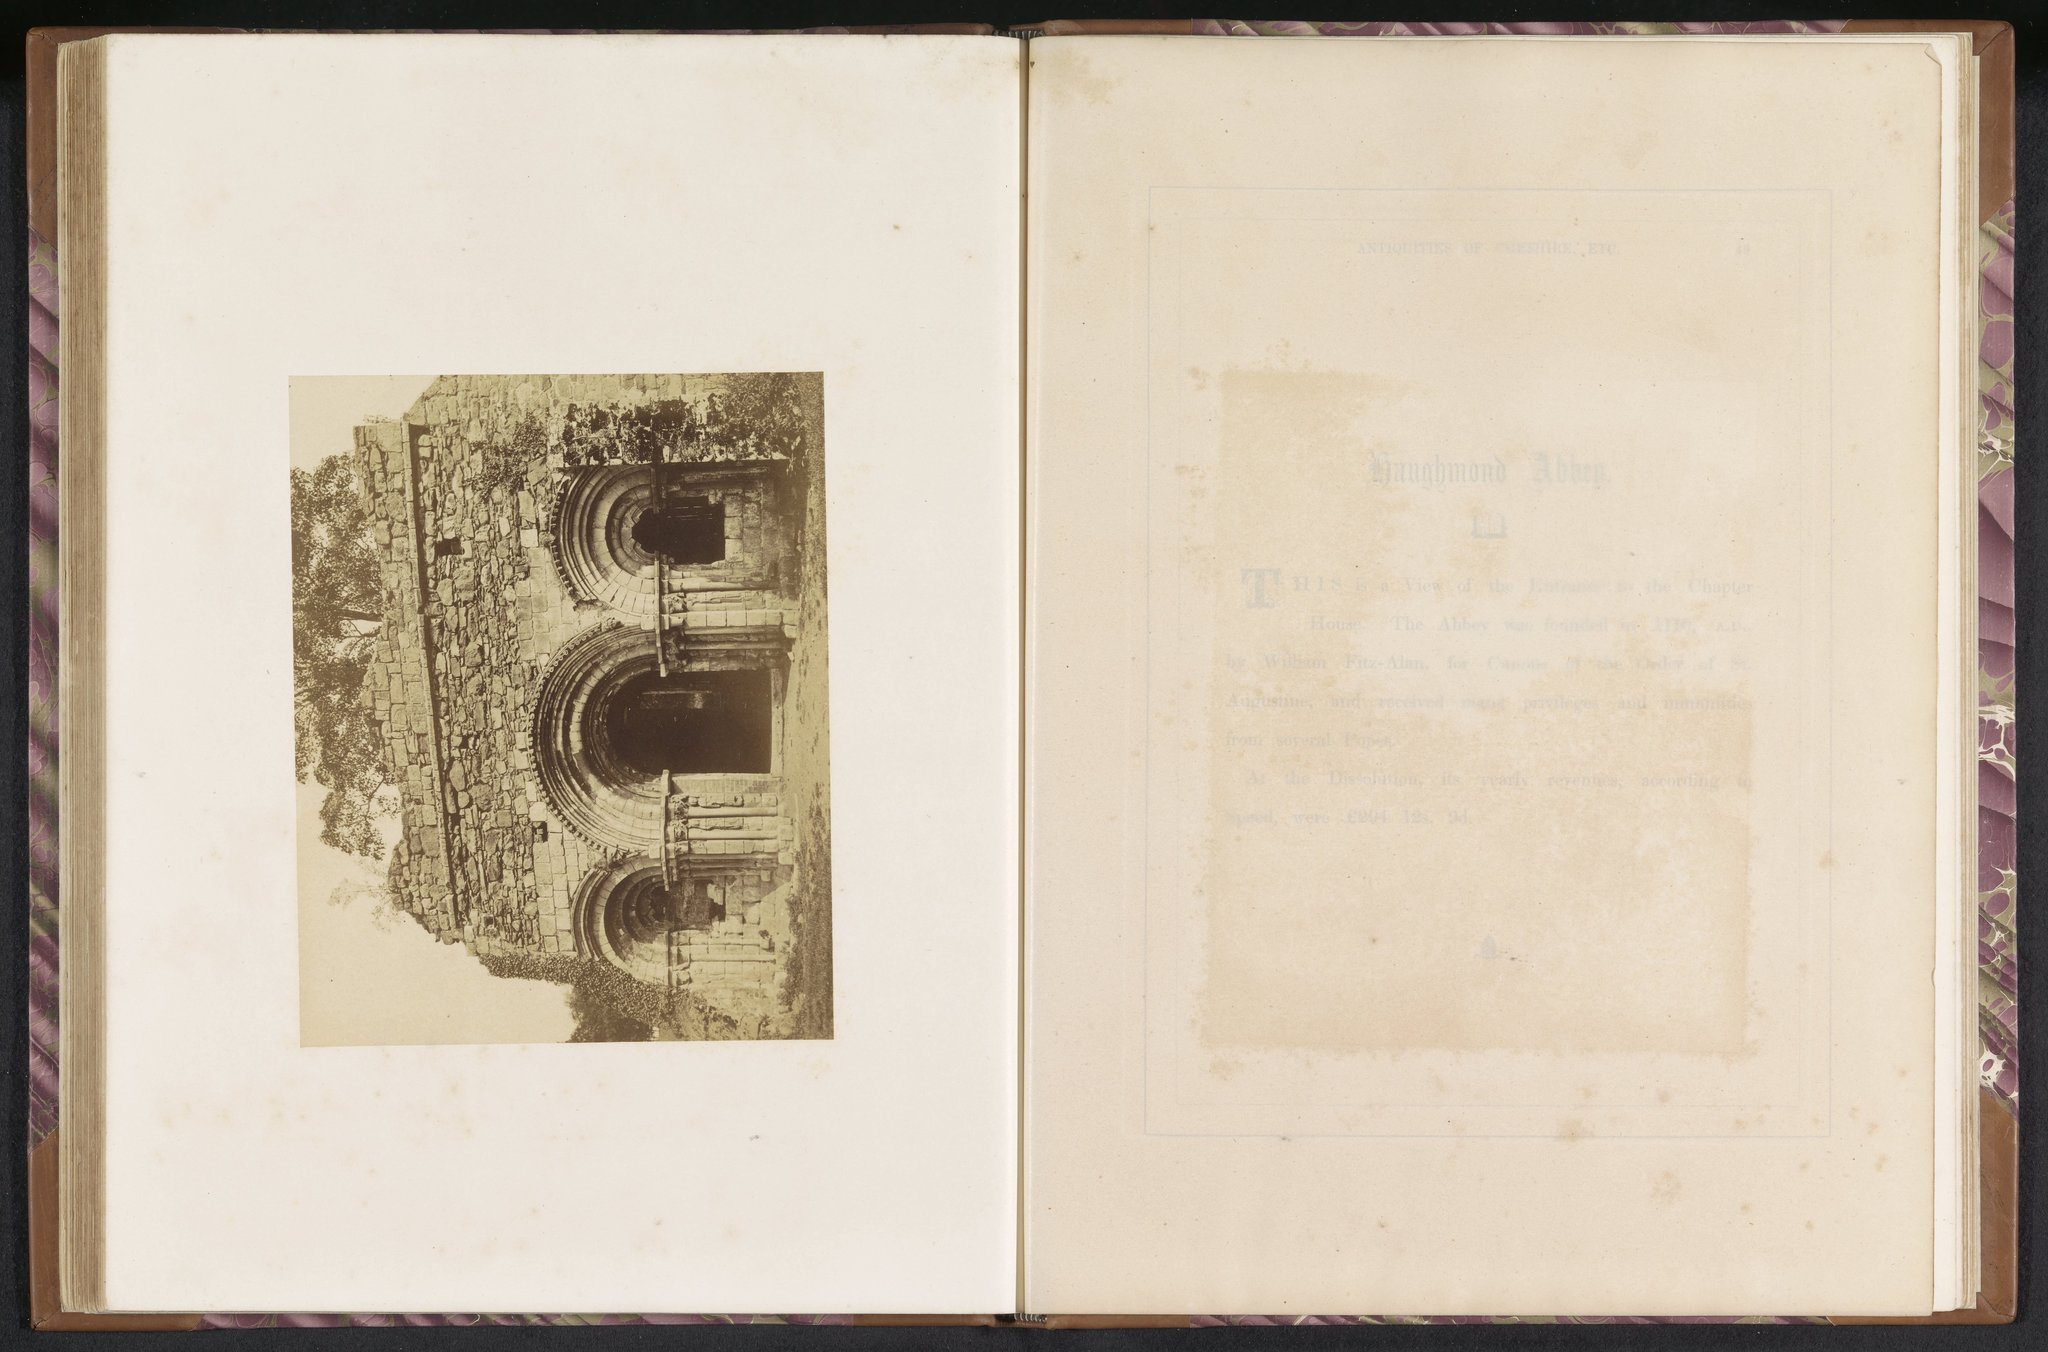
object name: page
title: Gezicht op resten van een poort van Haughmond Abbey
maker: william bryans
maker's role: fotograaf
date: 1850-1858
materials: photographic support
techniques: albumen print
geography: haughmond abbey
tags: abbey, monastery, convent ~ roman catholic church, gate, entrance, ruin of church, monastery, etc.